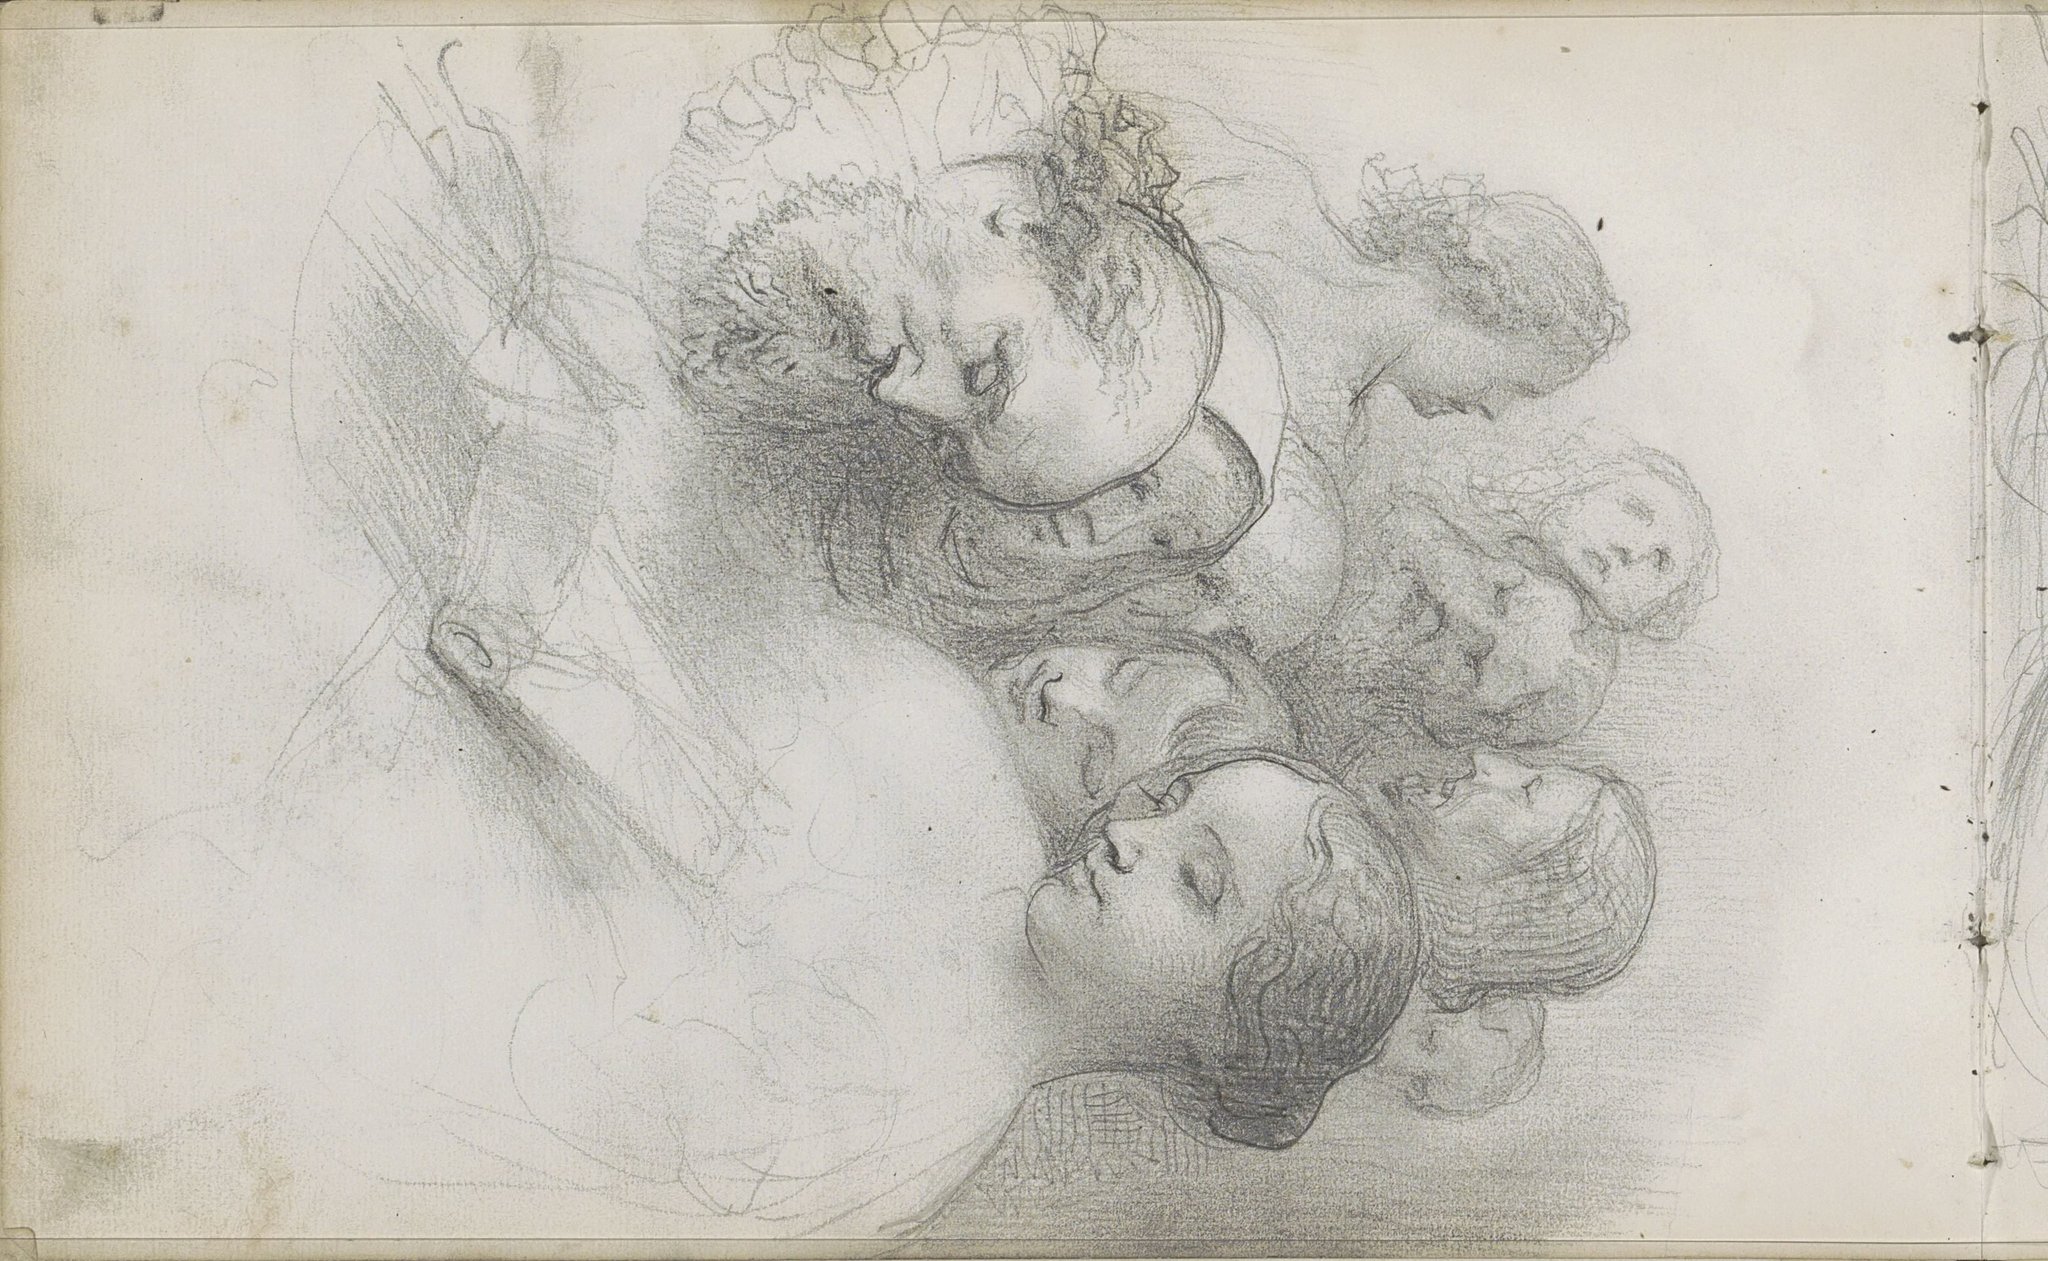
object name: sketchbook leaf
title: Groep van tien mannen en vrouwen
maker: bastiaan de poorter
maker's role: painter, print maker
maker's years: 1813-1880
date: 1858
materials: paper, pencil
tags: head (human), historical costume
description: Tien mannen en vrouwen afgebeeld met de hoofden bij elkaar. Eén van de mannen draagt historisch kostuum. Blad 37 verso uit een gecombineerd album amicorum en schetsboek met in totaal 39 bladen.